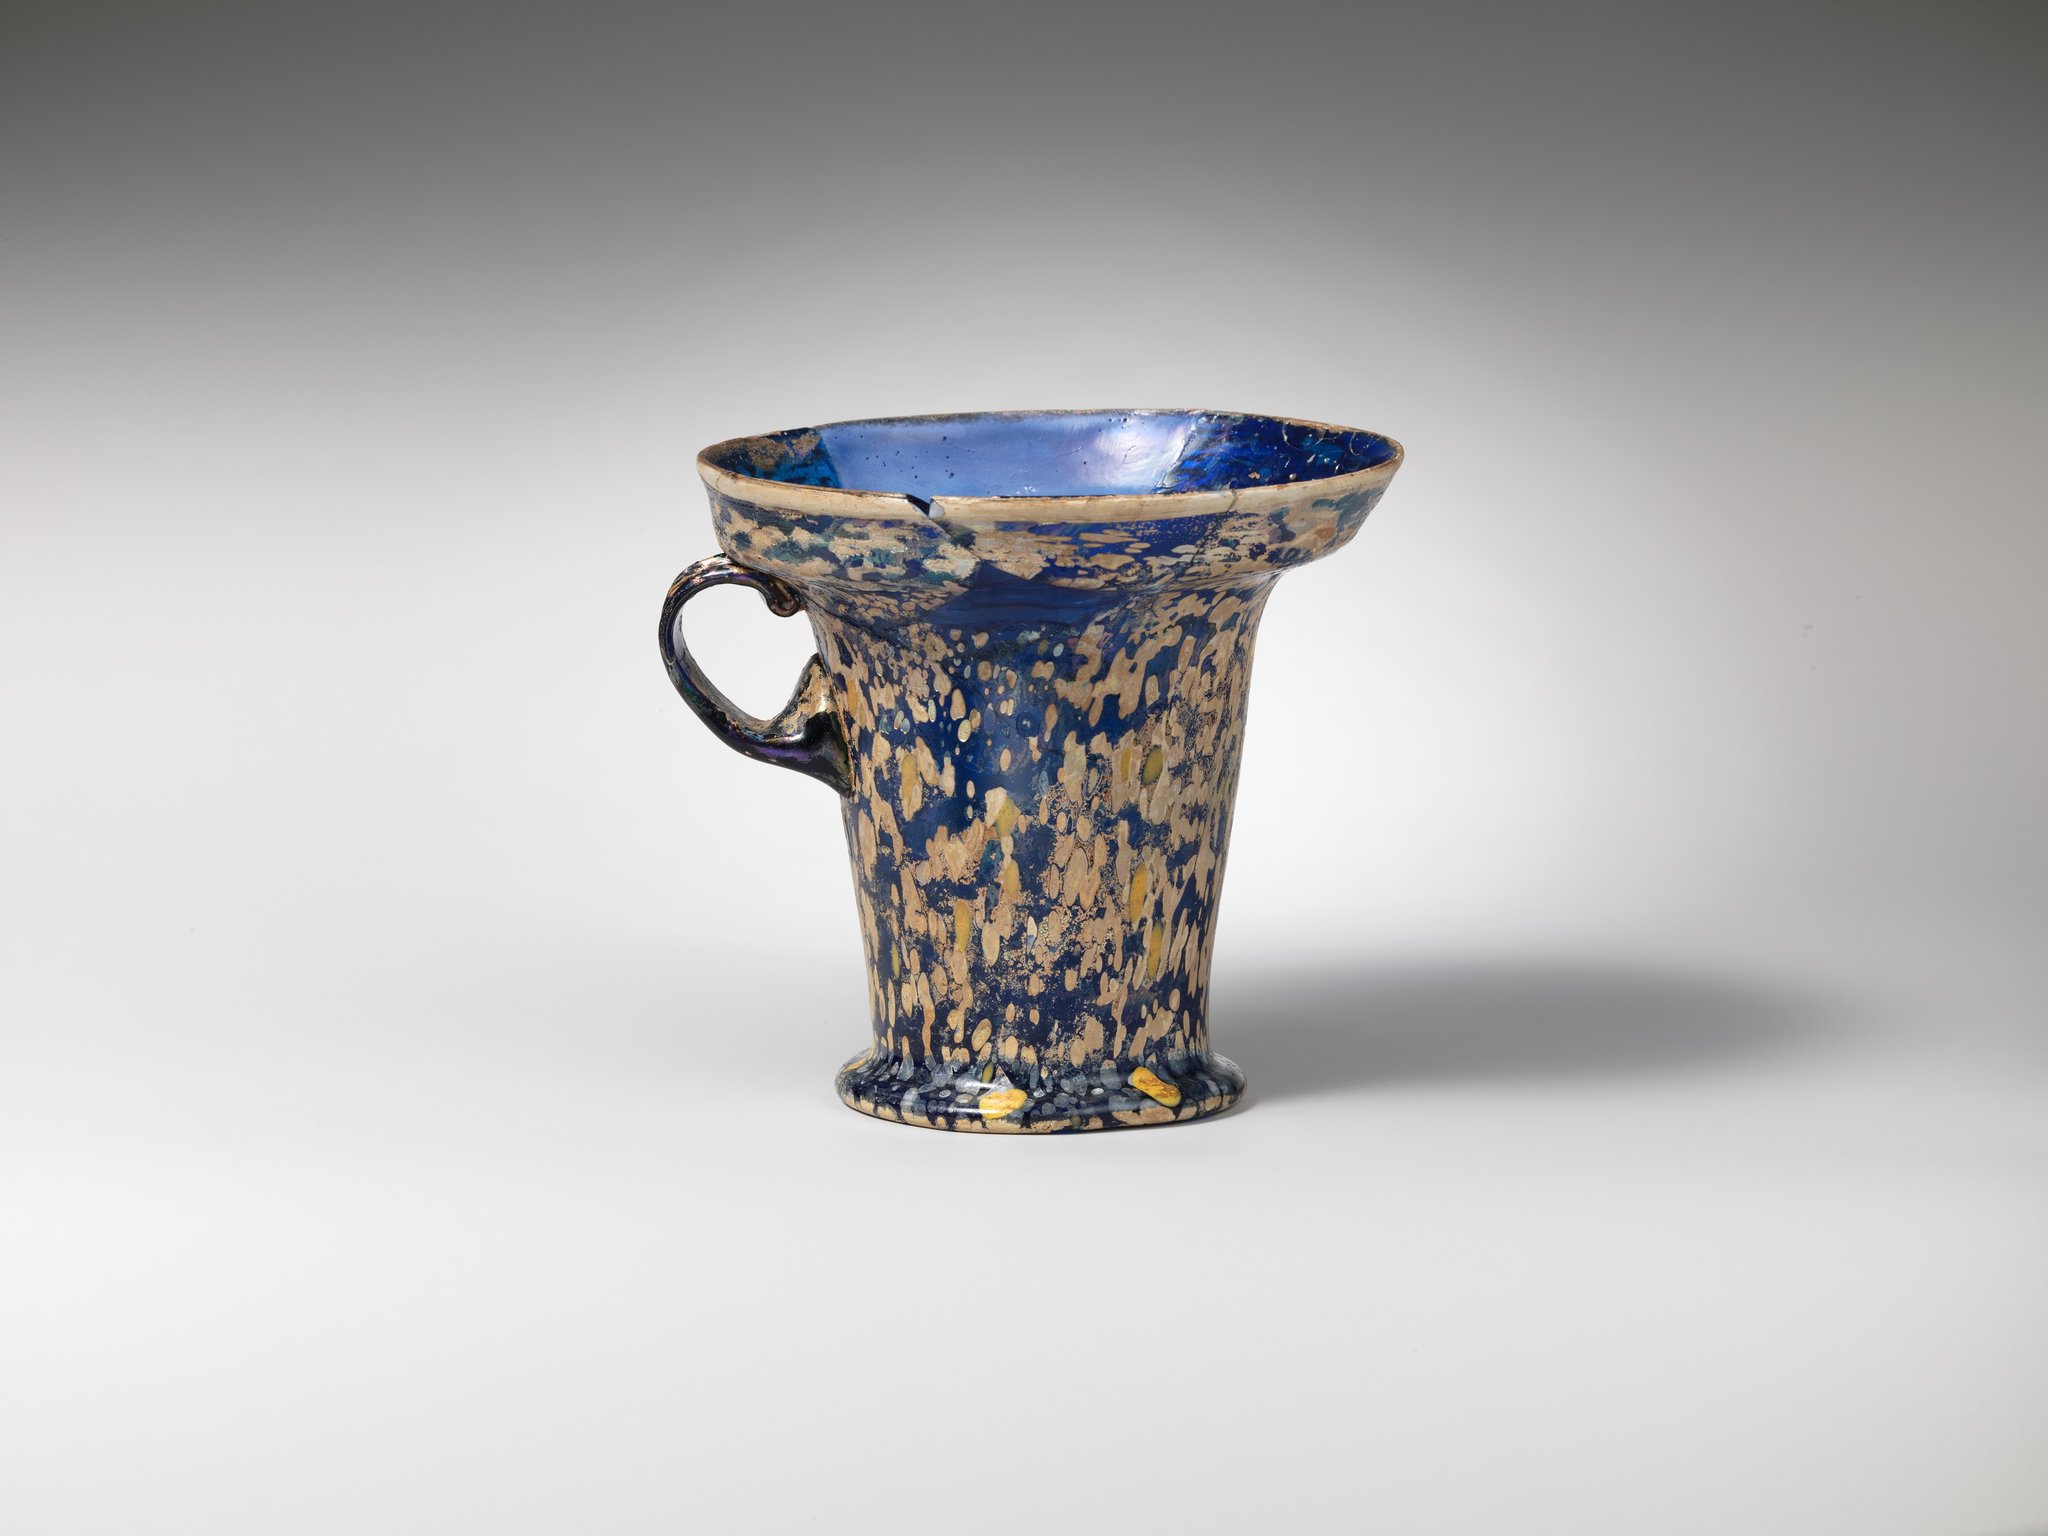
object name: cup, modiolus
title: Glass modiolus (one-handled drinking cup)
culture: roman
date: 1-100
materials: glass